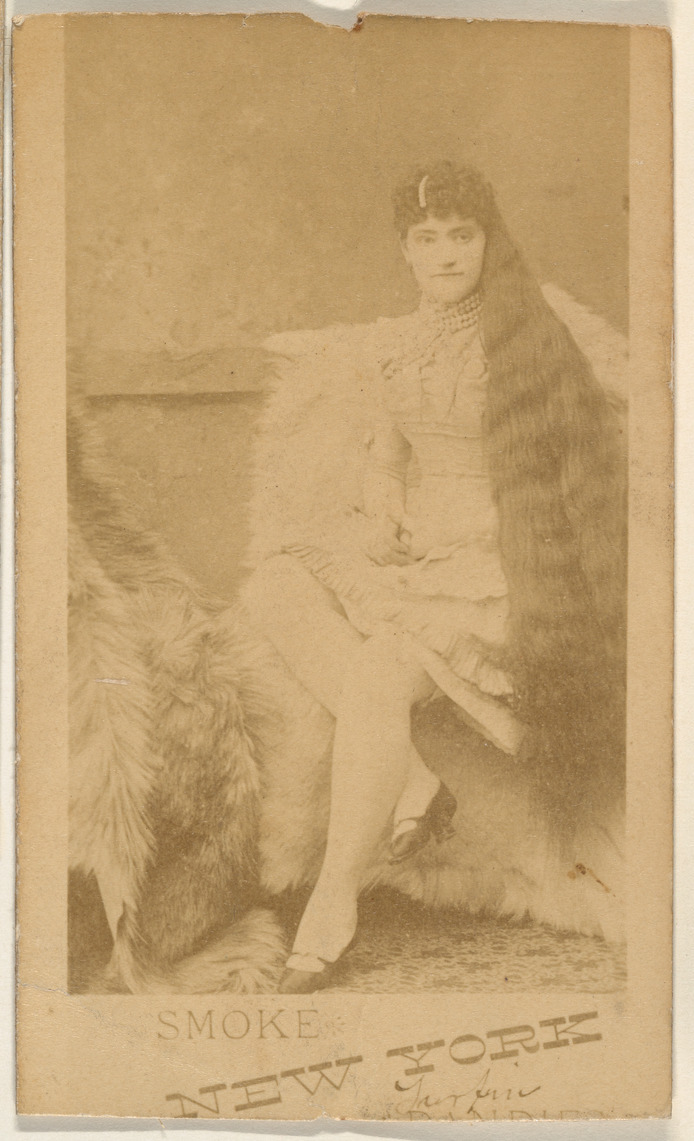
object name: photograph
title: Actress with knee-length hair, from the series Actresses (N674), promoting New York Dandies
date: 1888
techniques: albumen silver print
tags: portraits,women,actresses